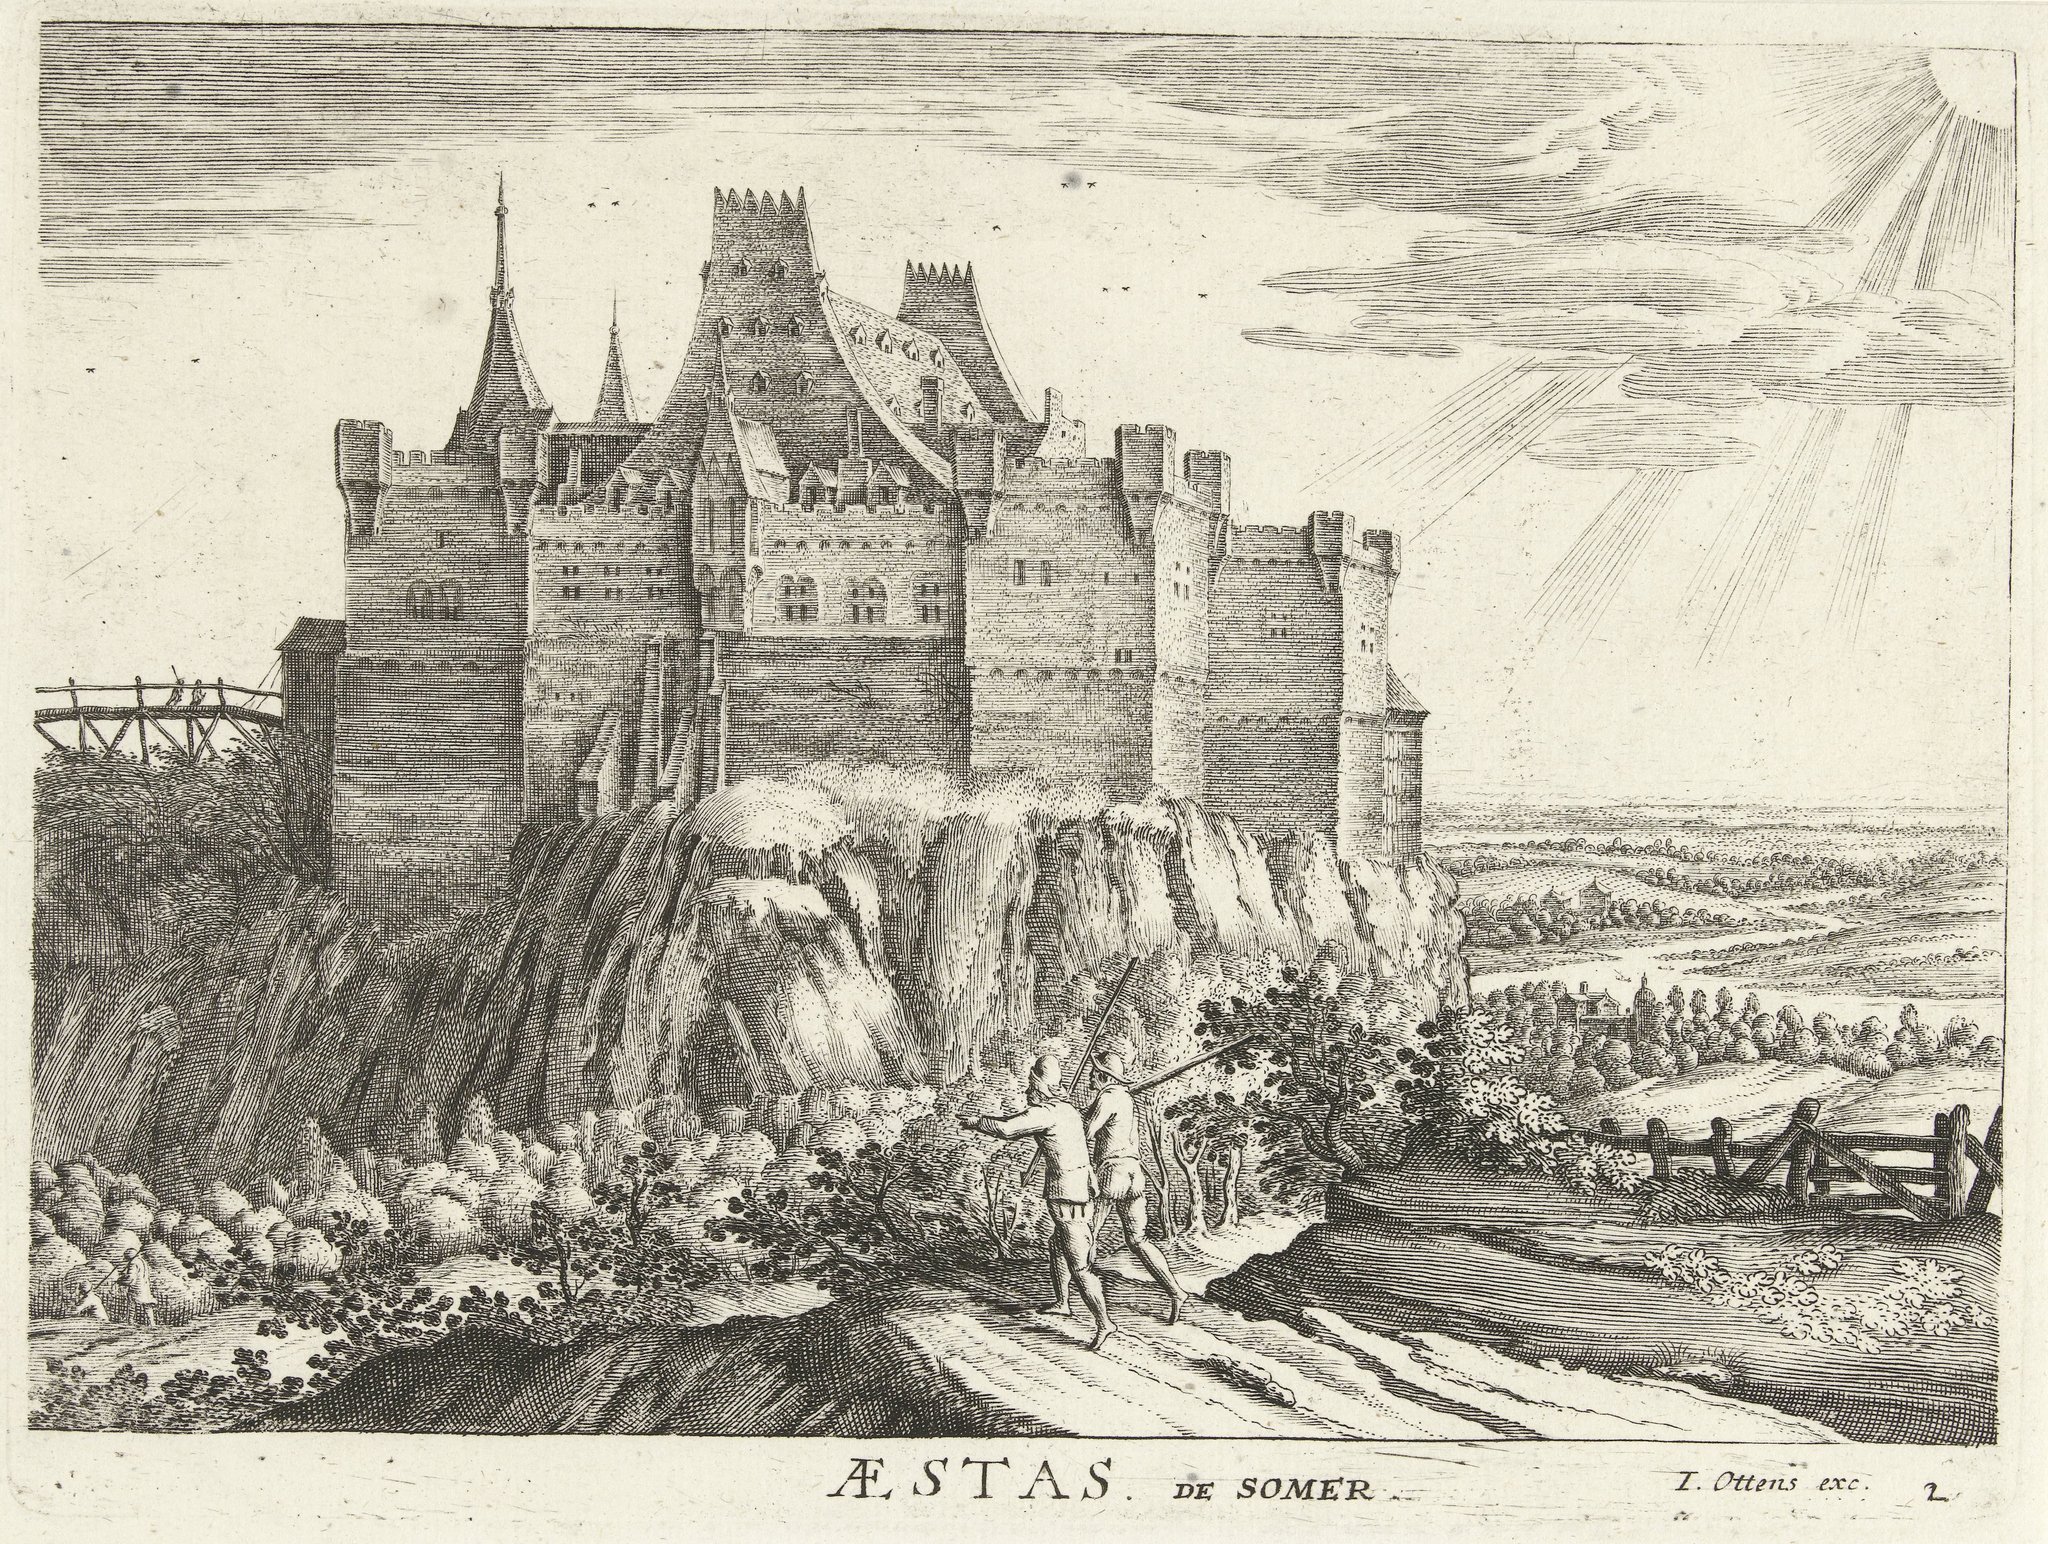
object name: print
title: Zomer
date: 1642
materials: paper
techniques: etching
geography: amsterdam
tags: summer landscape; landscape symbolizing summer (the four seasons of the year)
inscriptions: collector's mark: Lugt 2228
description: Landschap met een kasteel. Op de voorgrond twee lopende figuren. Prent uit een serie van de vier seizoenen.